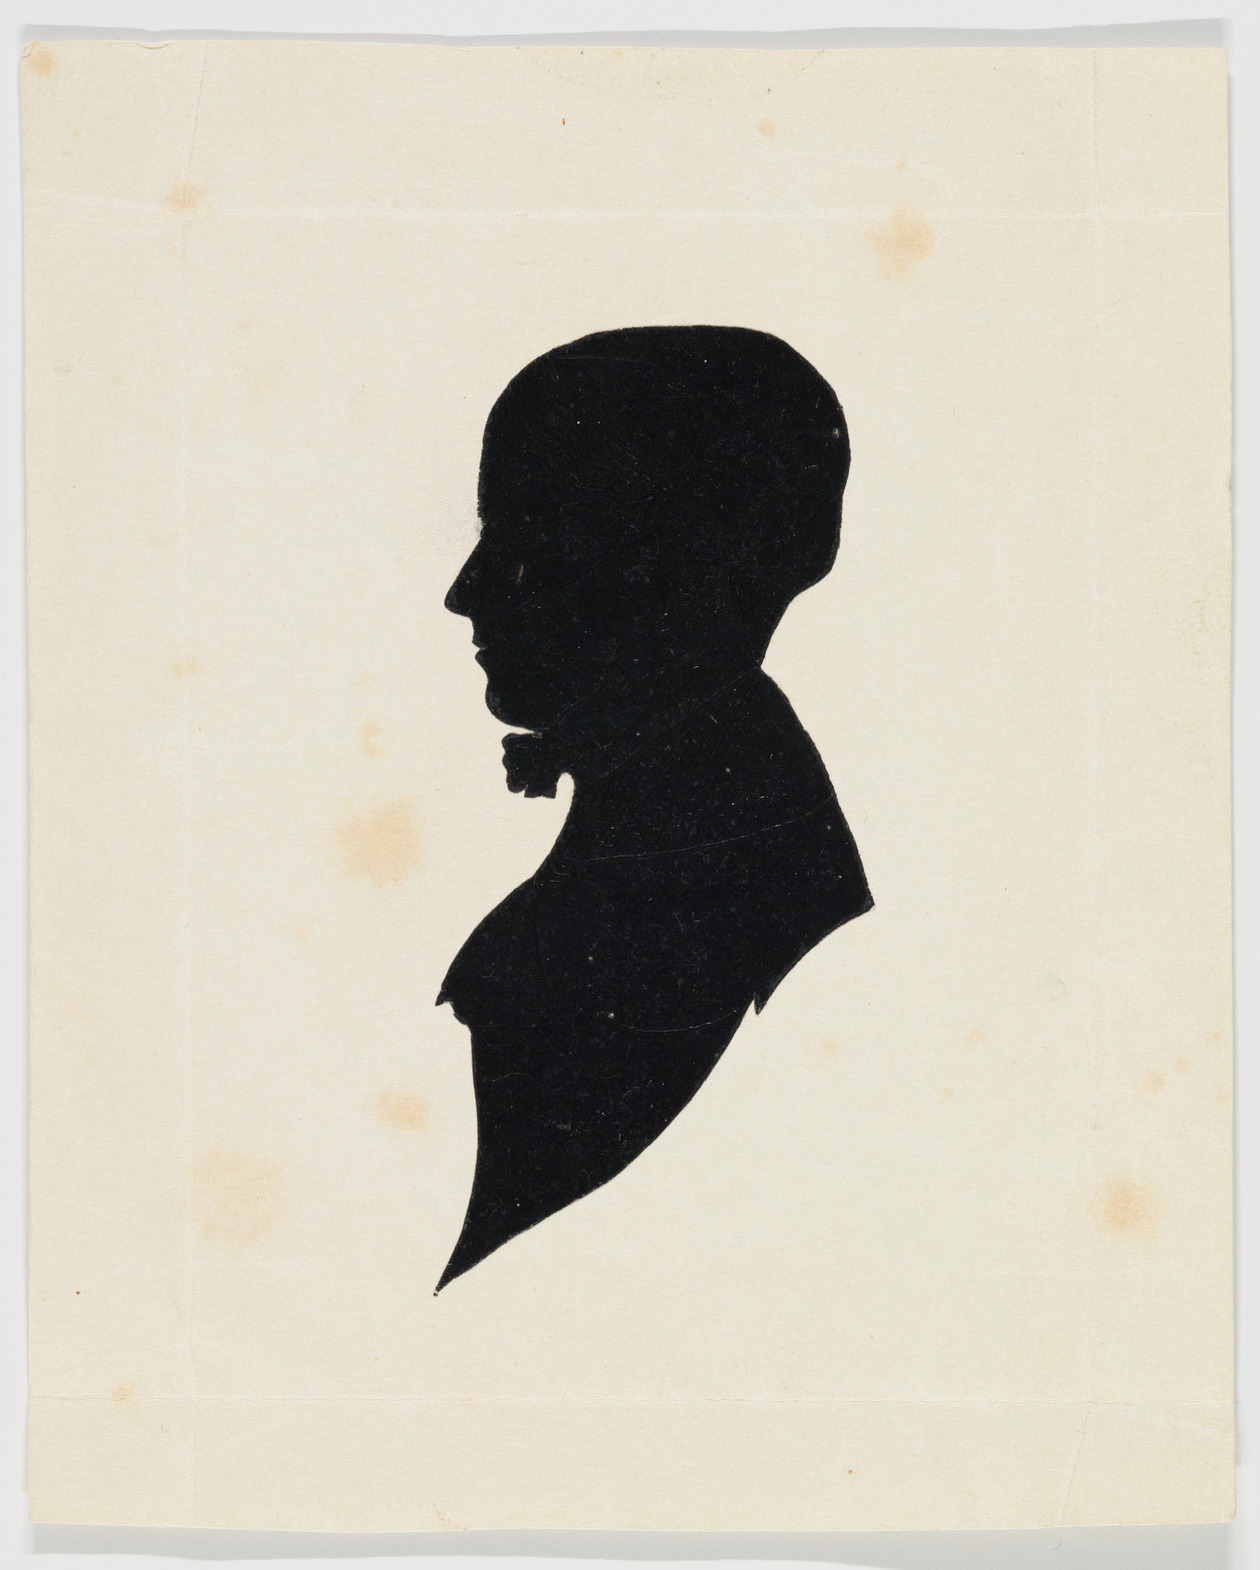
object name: cut paper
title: Profile portrait of a woman facing left (Constanze Håuser?)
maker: anonymous, german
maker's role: artist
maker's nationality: german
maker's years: 1400-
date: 1773-1820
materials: paper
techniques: cutting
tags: profiles,women